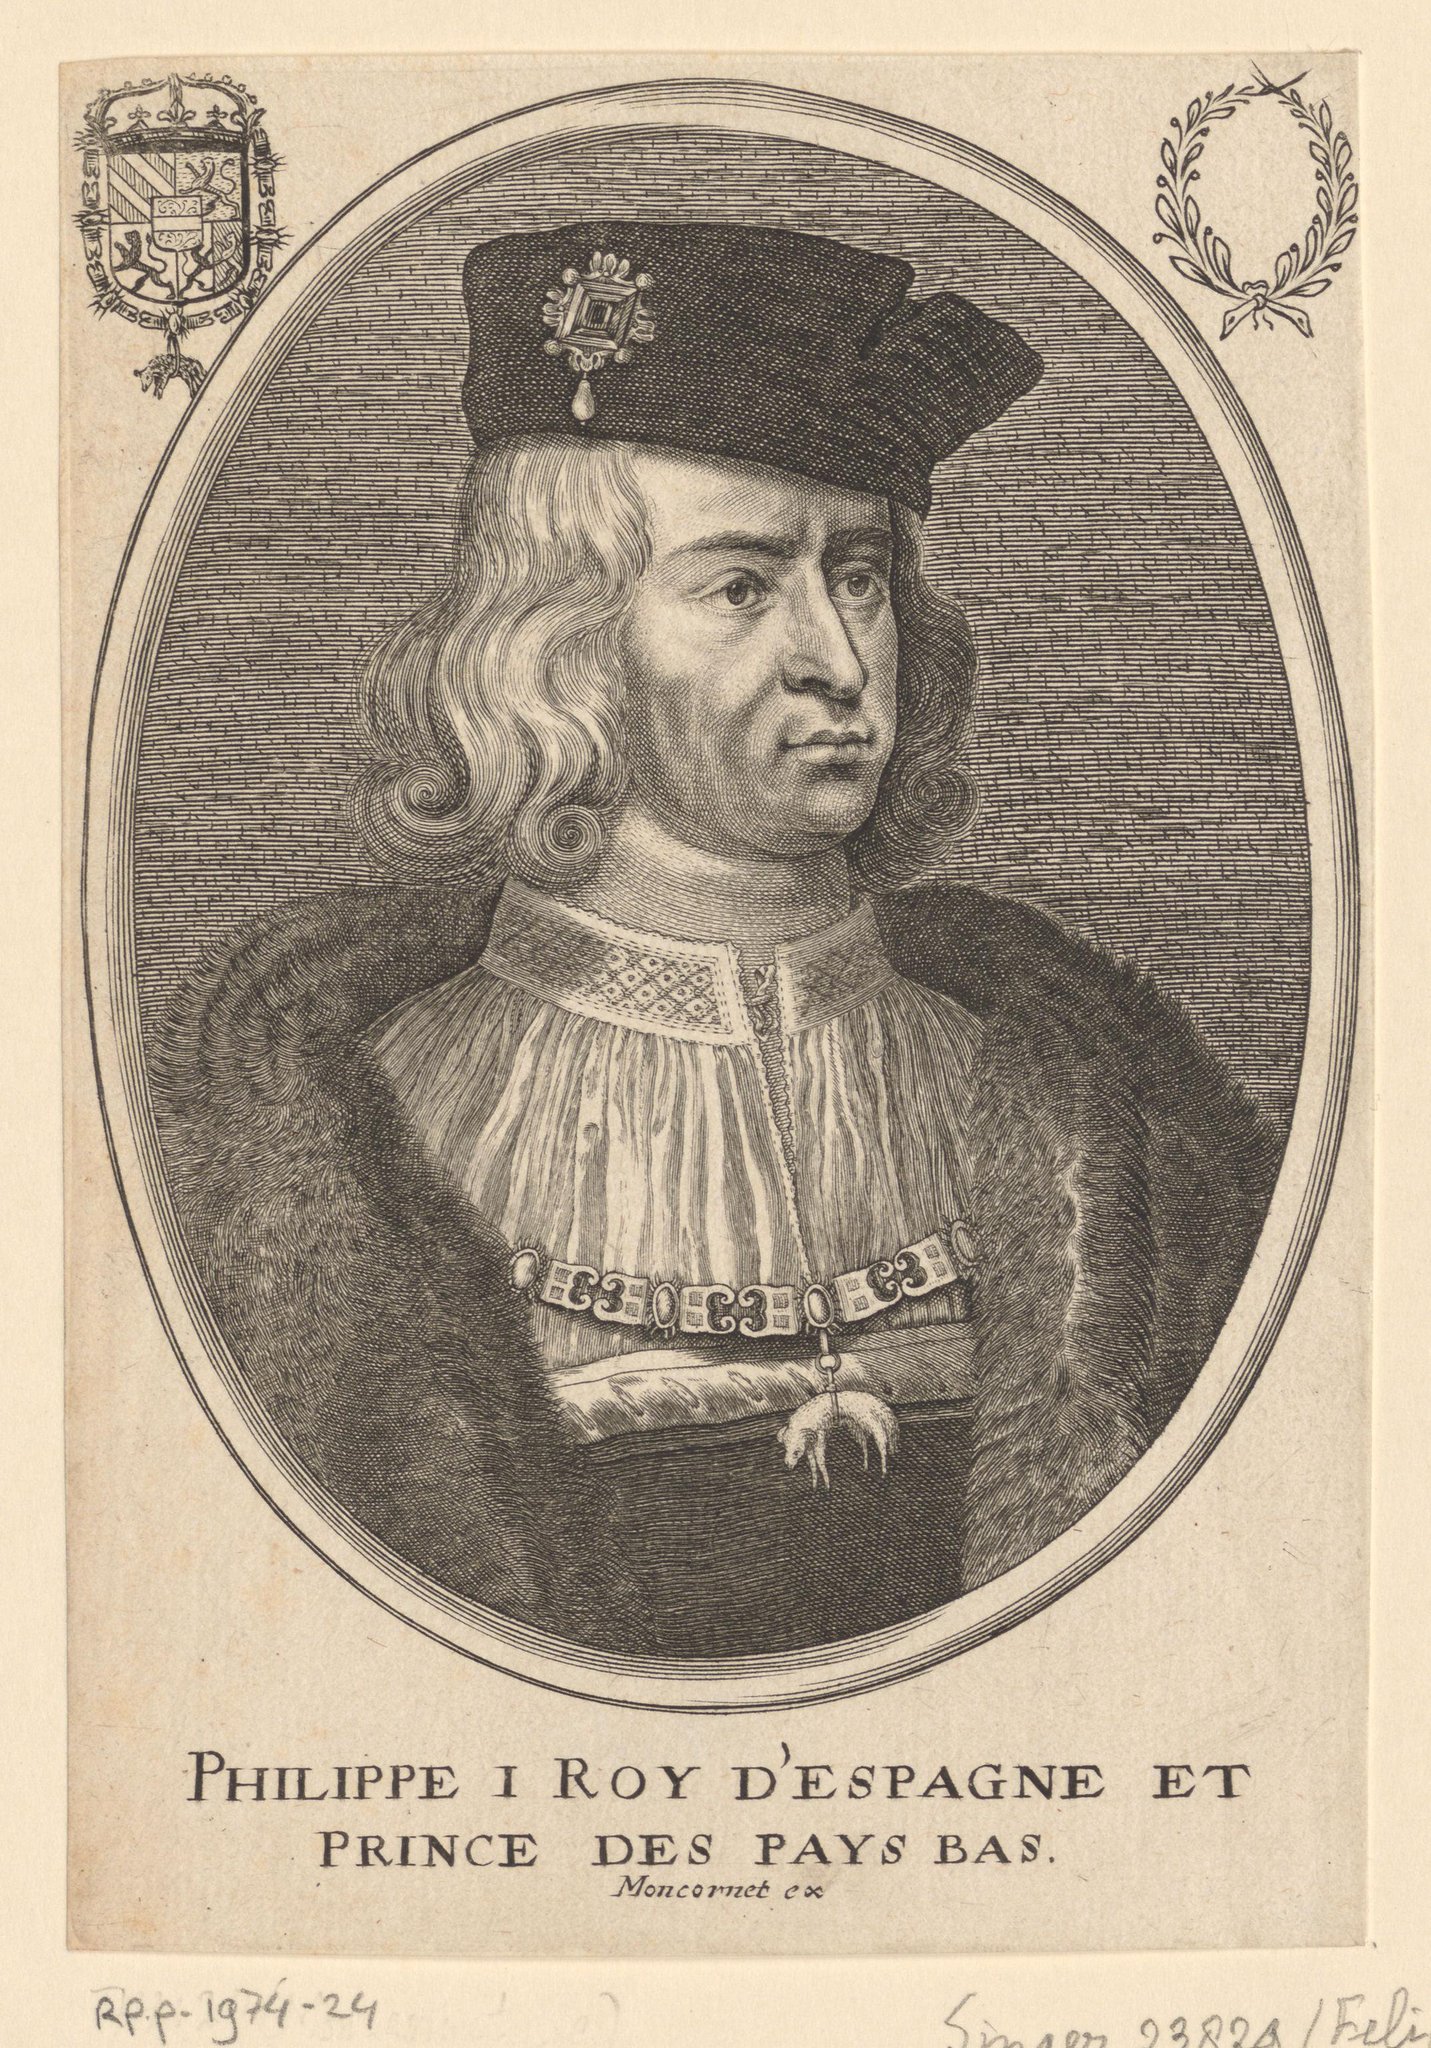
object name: print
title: Portret van Filips de Schone, hertog van Bourgondië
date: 1652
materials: paper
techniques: engraving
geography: paris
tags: bruges, filips de schone (hertog van bourgondië), adult man, historical persons, knighthood order of the golden fleece, armorial bearing, heraldry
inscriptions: collector's mark: Lugt 2228, collector's mark: Lugt 2760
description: Waarschijnlijk onderdeel van een serie portretten, in catalogi bekend als 'Recueil de portraits des rois, princes et seigneurs français et étrangers'. Zie Van Someren.